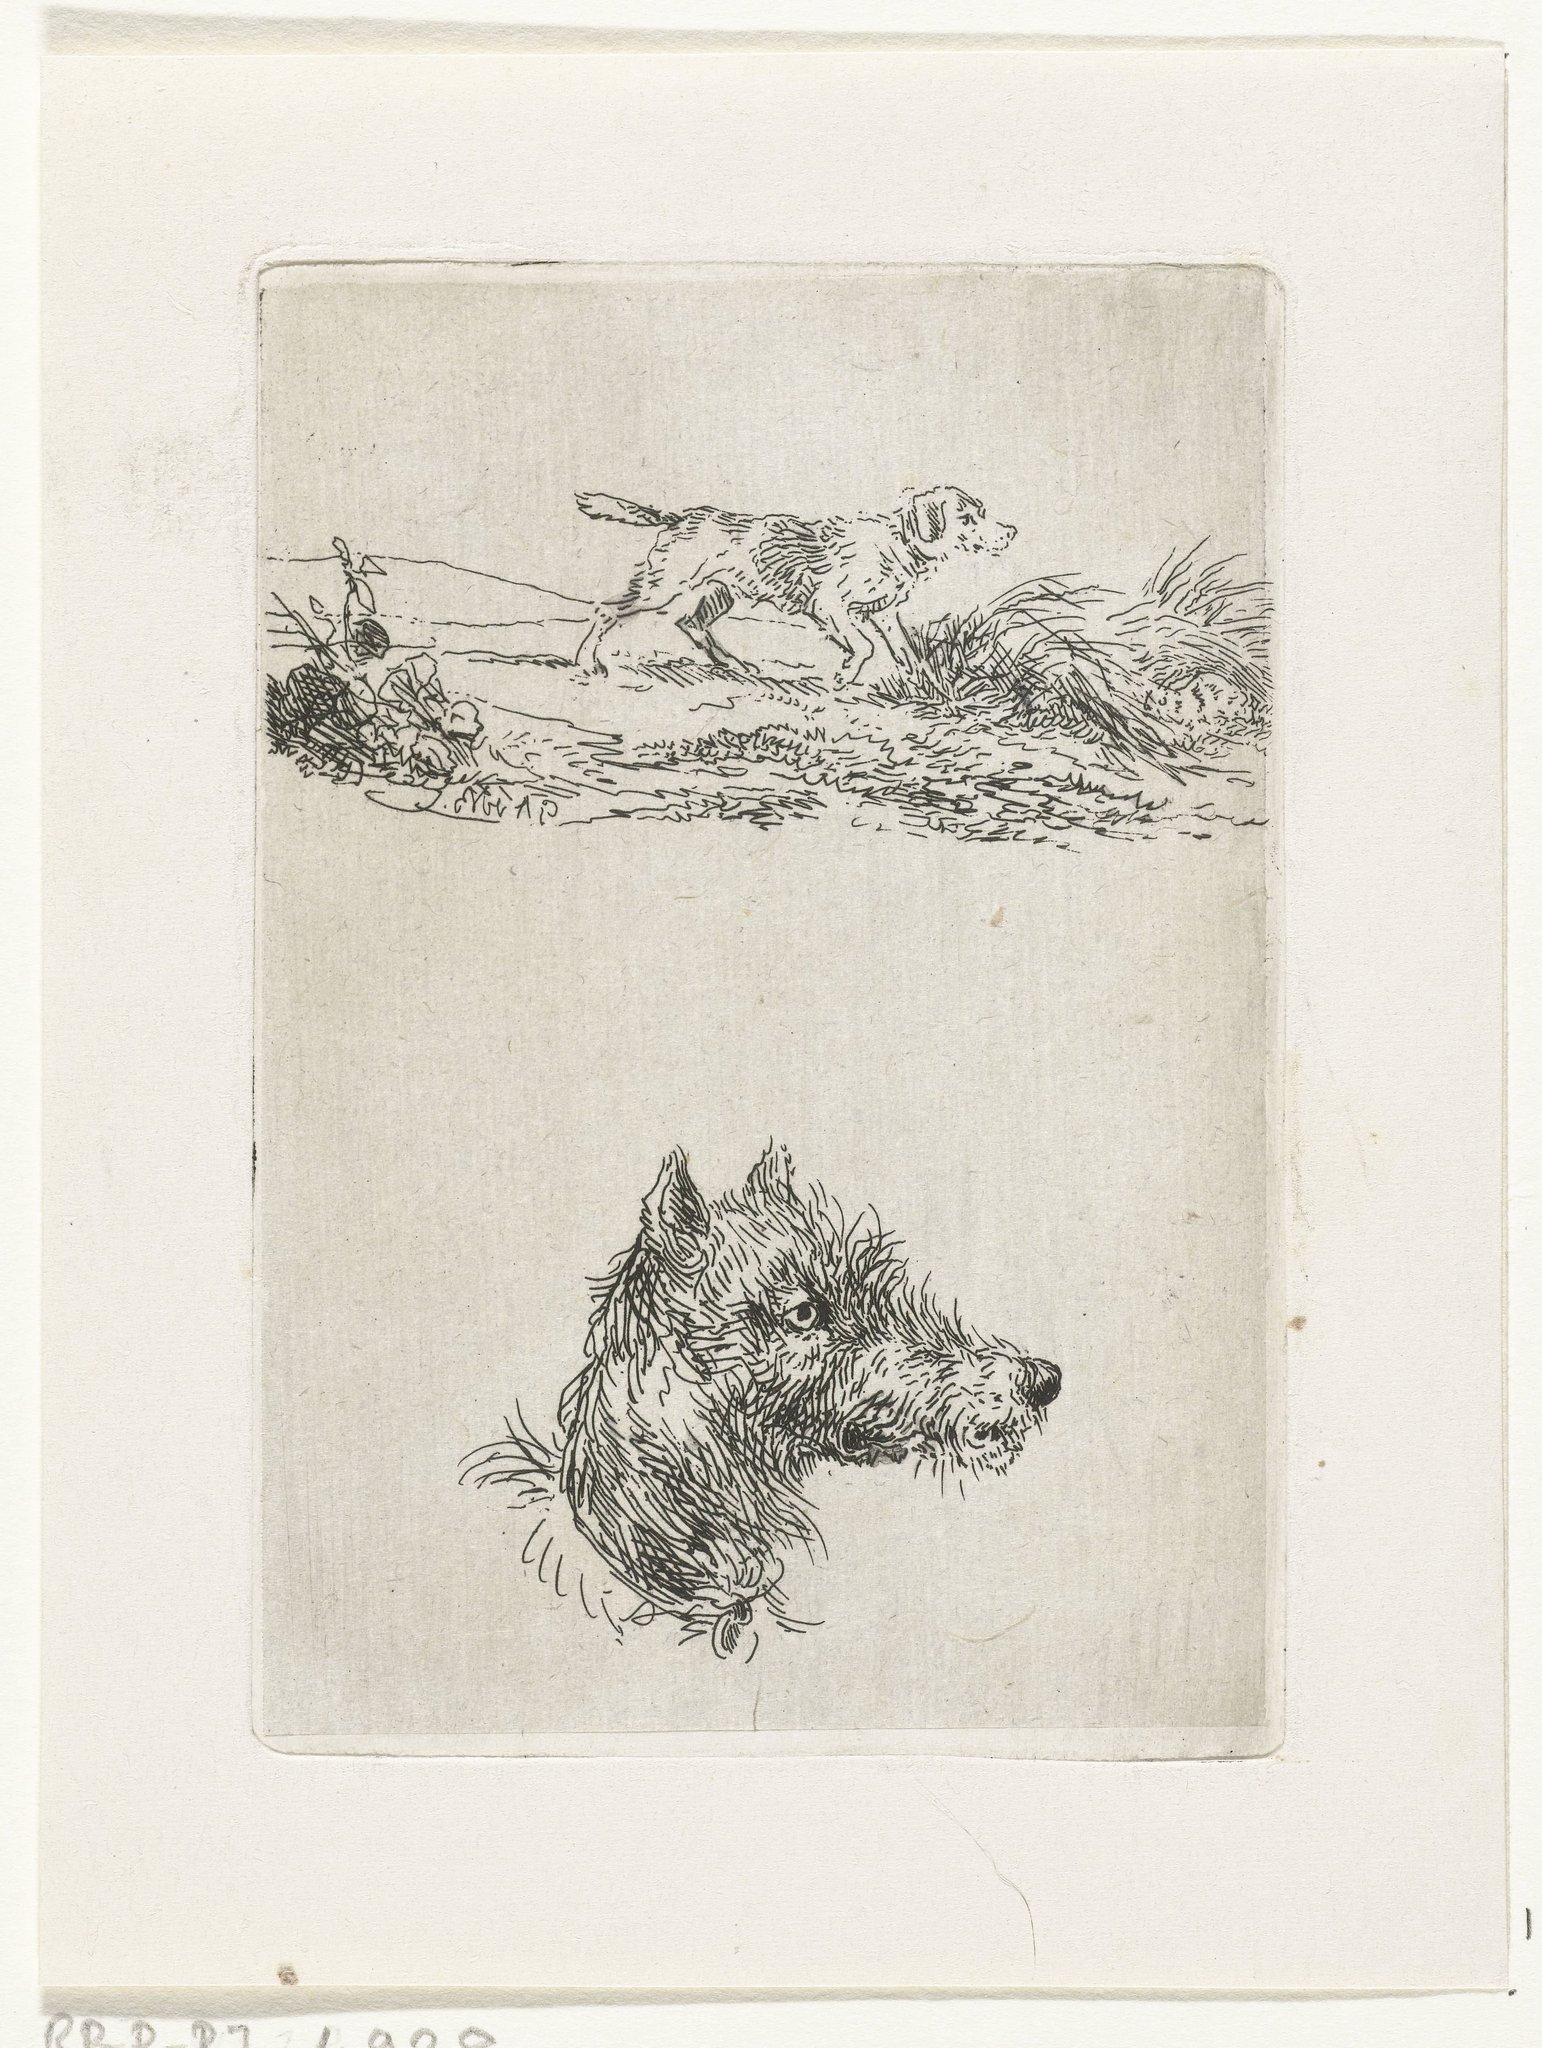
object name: print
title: Hondekop en hond in landschap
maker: guillaume anne van der brugghen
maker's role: draughtsman, print maker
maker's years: 1812-1891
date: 1856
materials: paper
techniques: etching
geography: netherlands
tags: dog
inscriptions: collector's mark: Lugt 2228